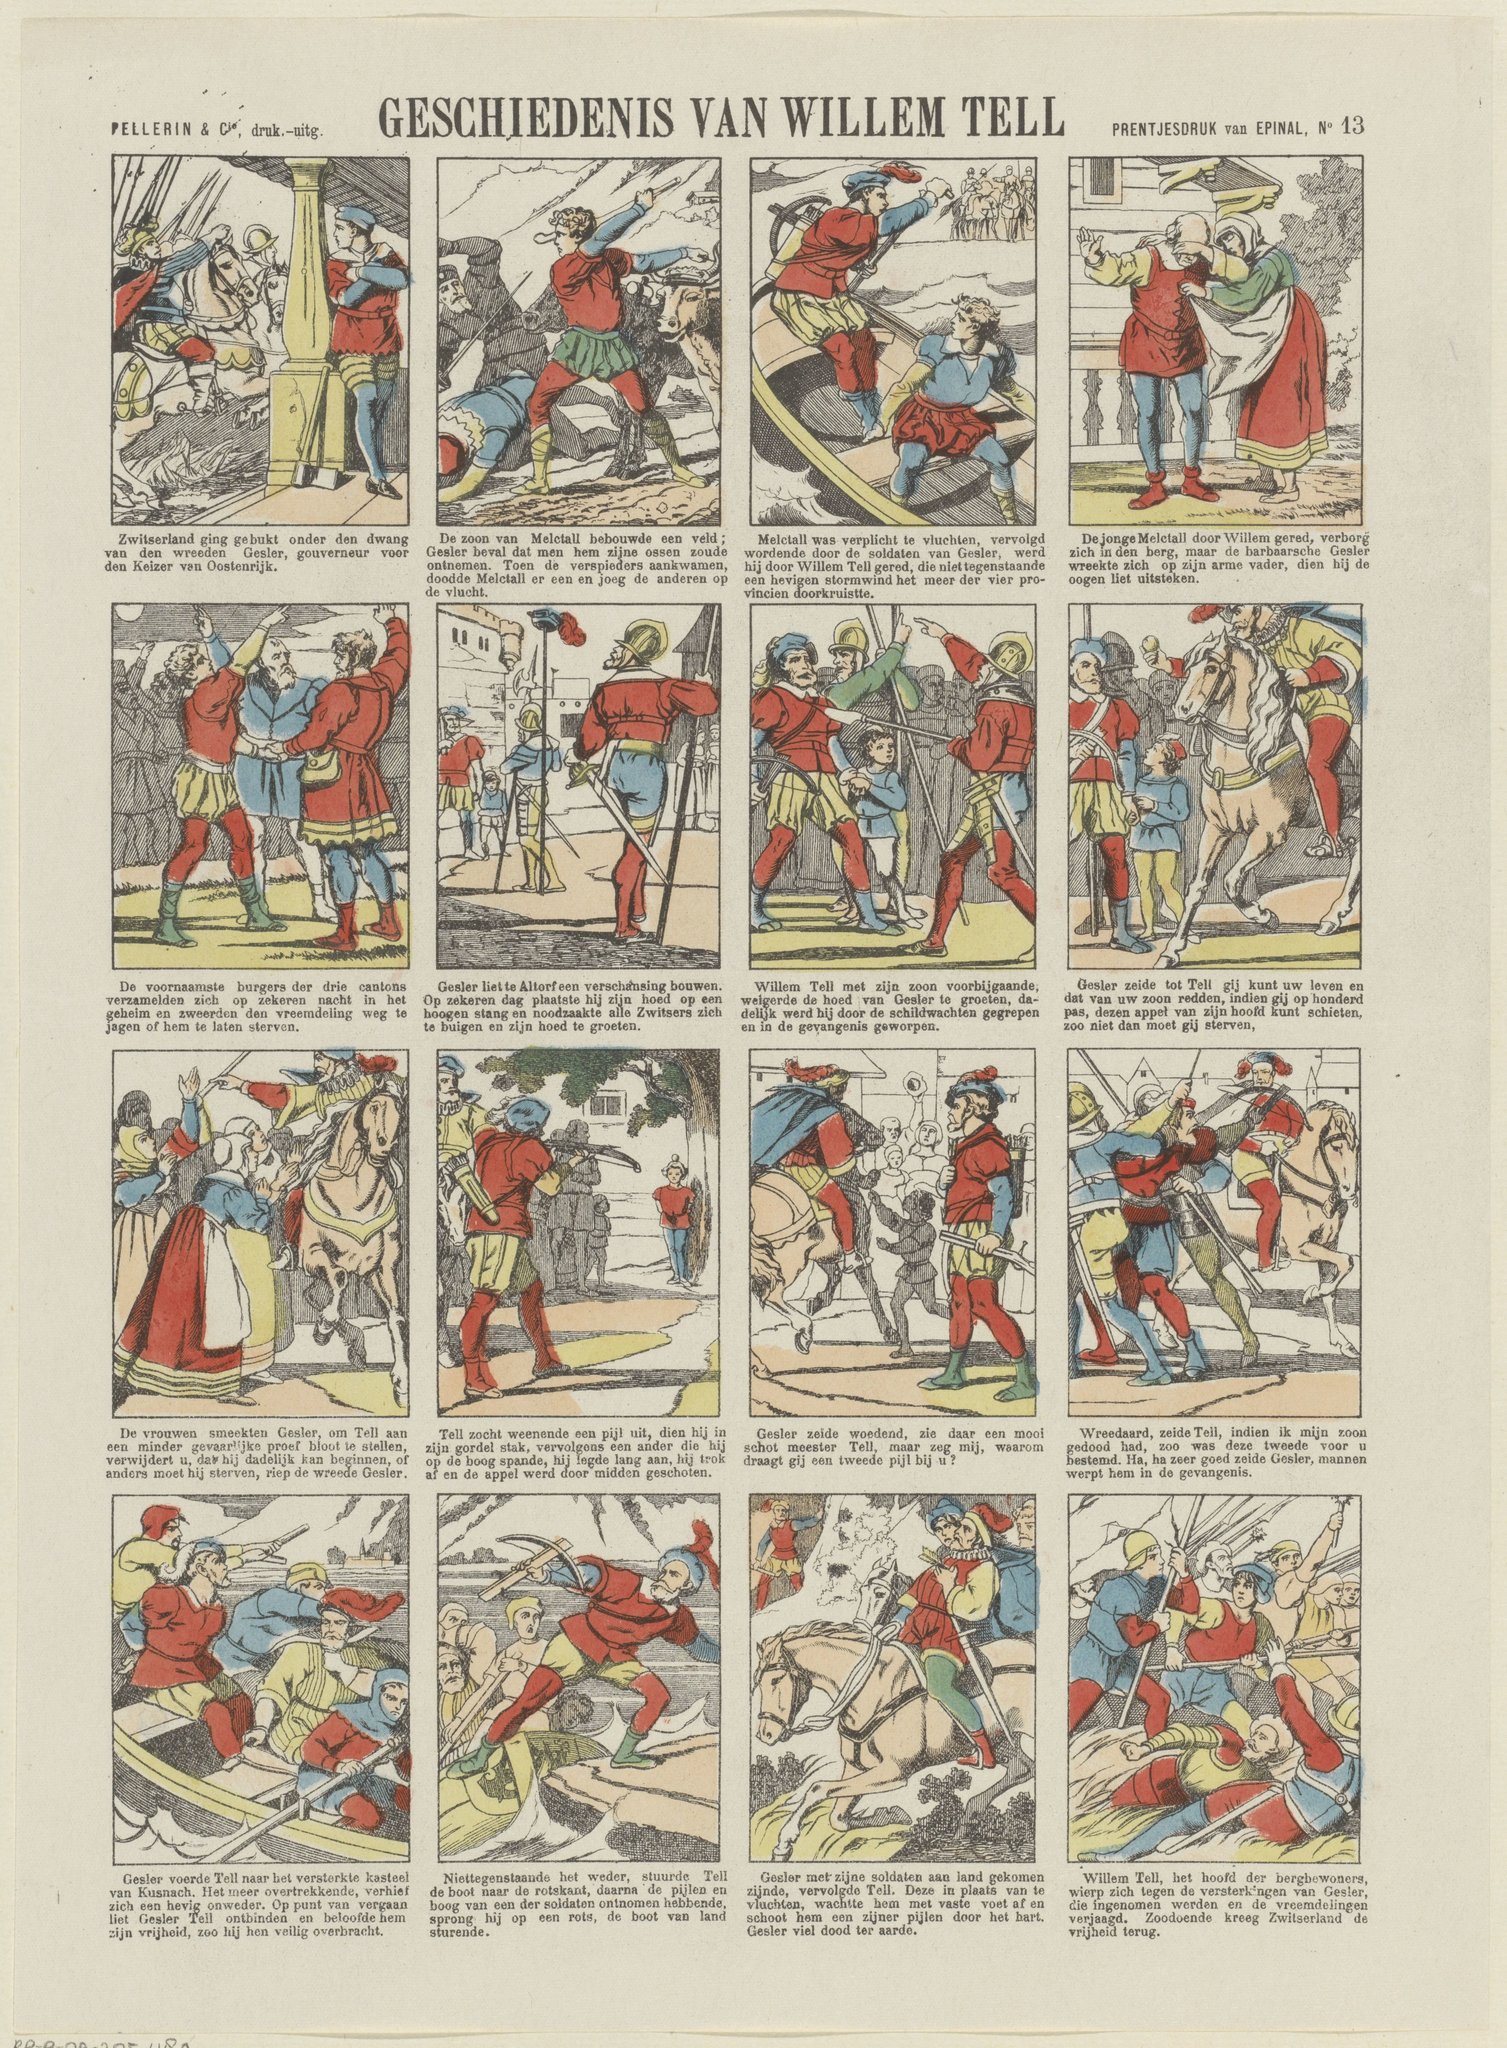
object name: popular print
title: Geschiedenis van Willem Tell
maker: Anonymous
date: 1902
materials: paper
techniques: colour, letterpress printing, lithograph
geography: epinal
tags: william tell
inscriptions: collector's mark: Lugt 2760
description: Blad met 16 voorstellingen uit het leven van Willem Tell. Onder elke afbeelding een onderschrift. Genummerd rechtsboven: No 13.